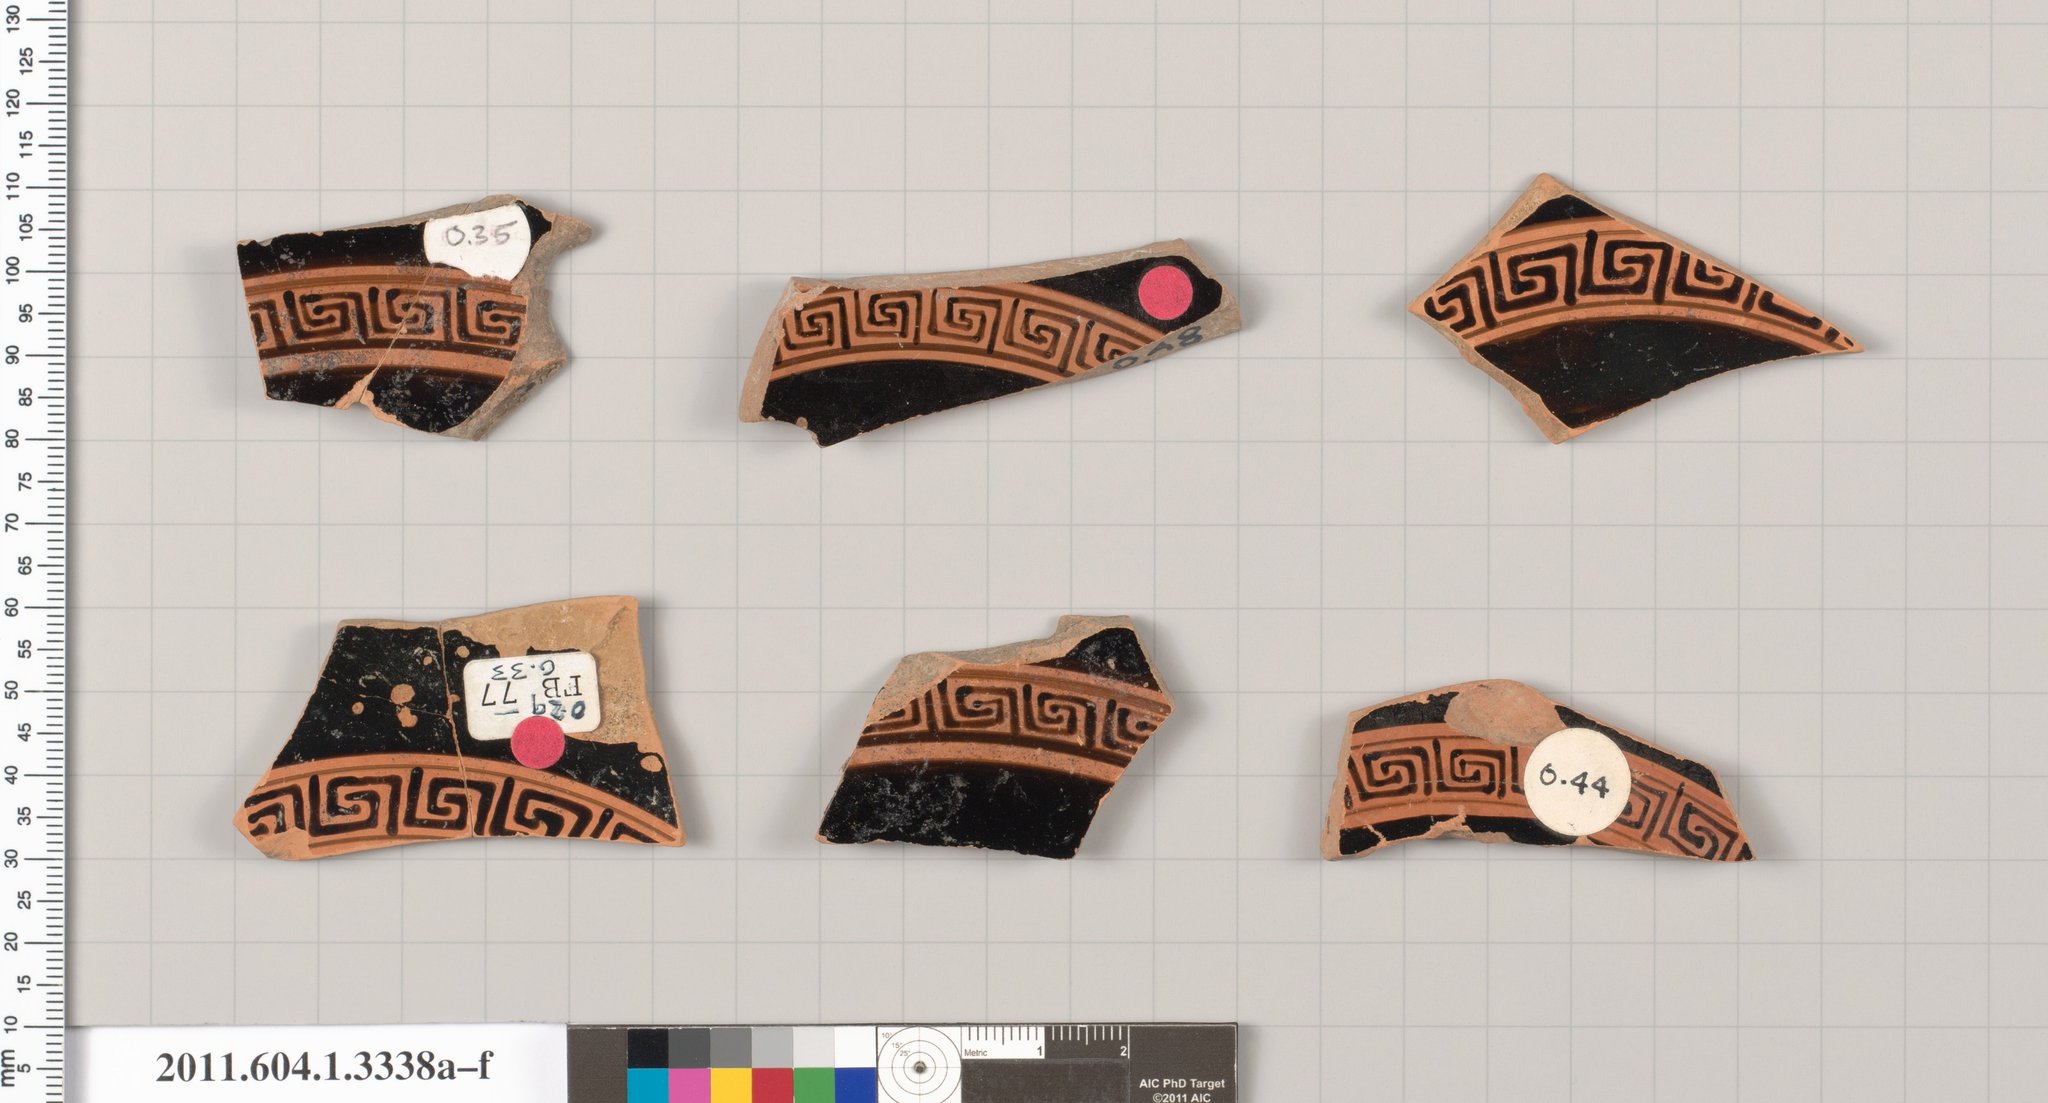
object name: kylix fragment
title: Terracotta fragments of kylikes (drinking cups)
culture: greek, attic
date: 500-470 BCE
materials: terracotta